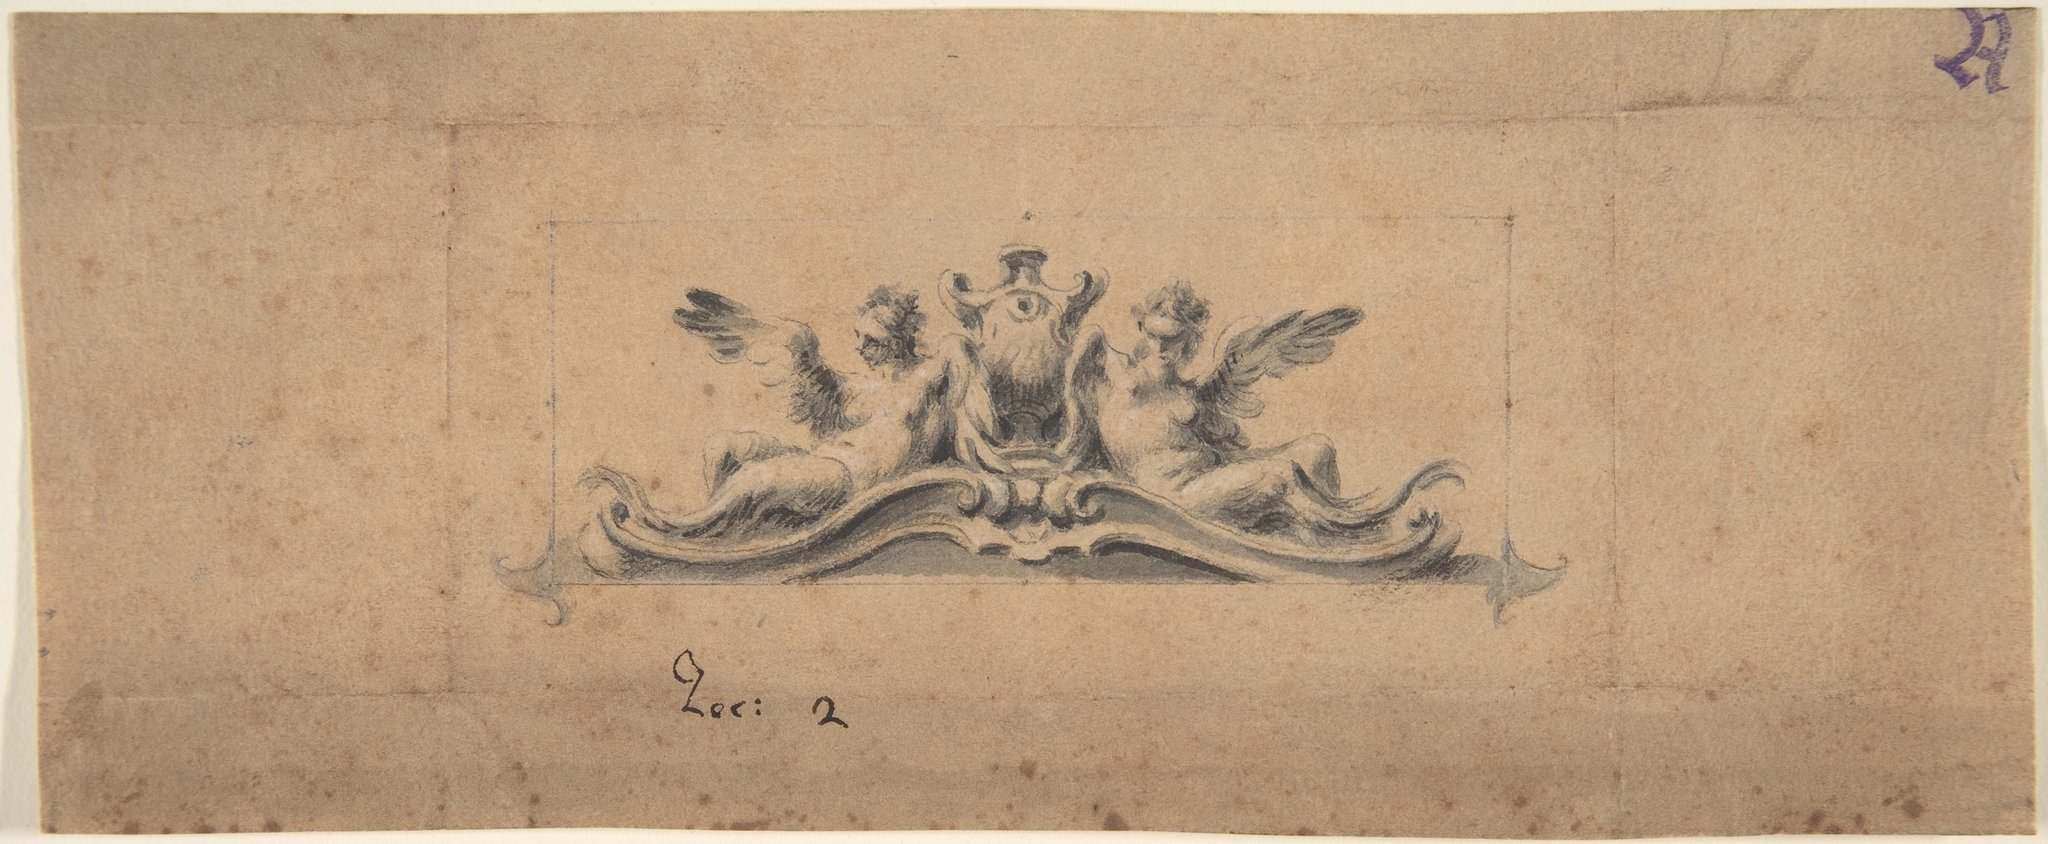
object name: drawing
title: Design for an Overdoor or Headpiece: Two Reclining Figures and Urn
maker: anonymous, italian, 18th century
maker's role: artist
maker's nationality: italian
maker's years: 1700-1800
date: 1701-1800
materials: chalk, graphite, ink, lead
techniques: brush, highlighting, pen, wash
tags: urns